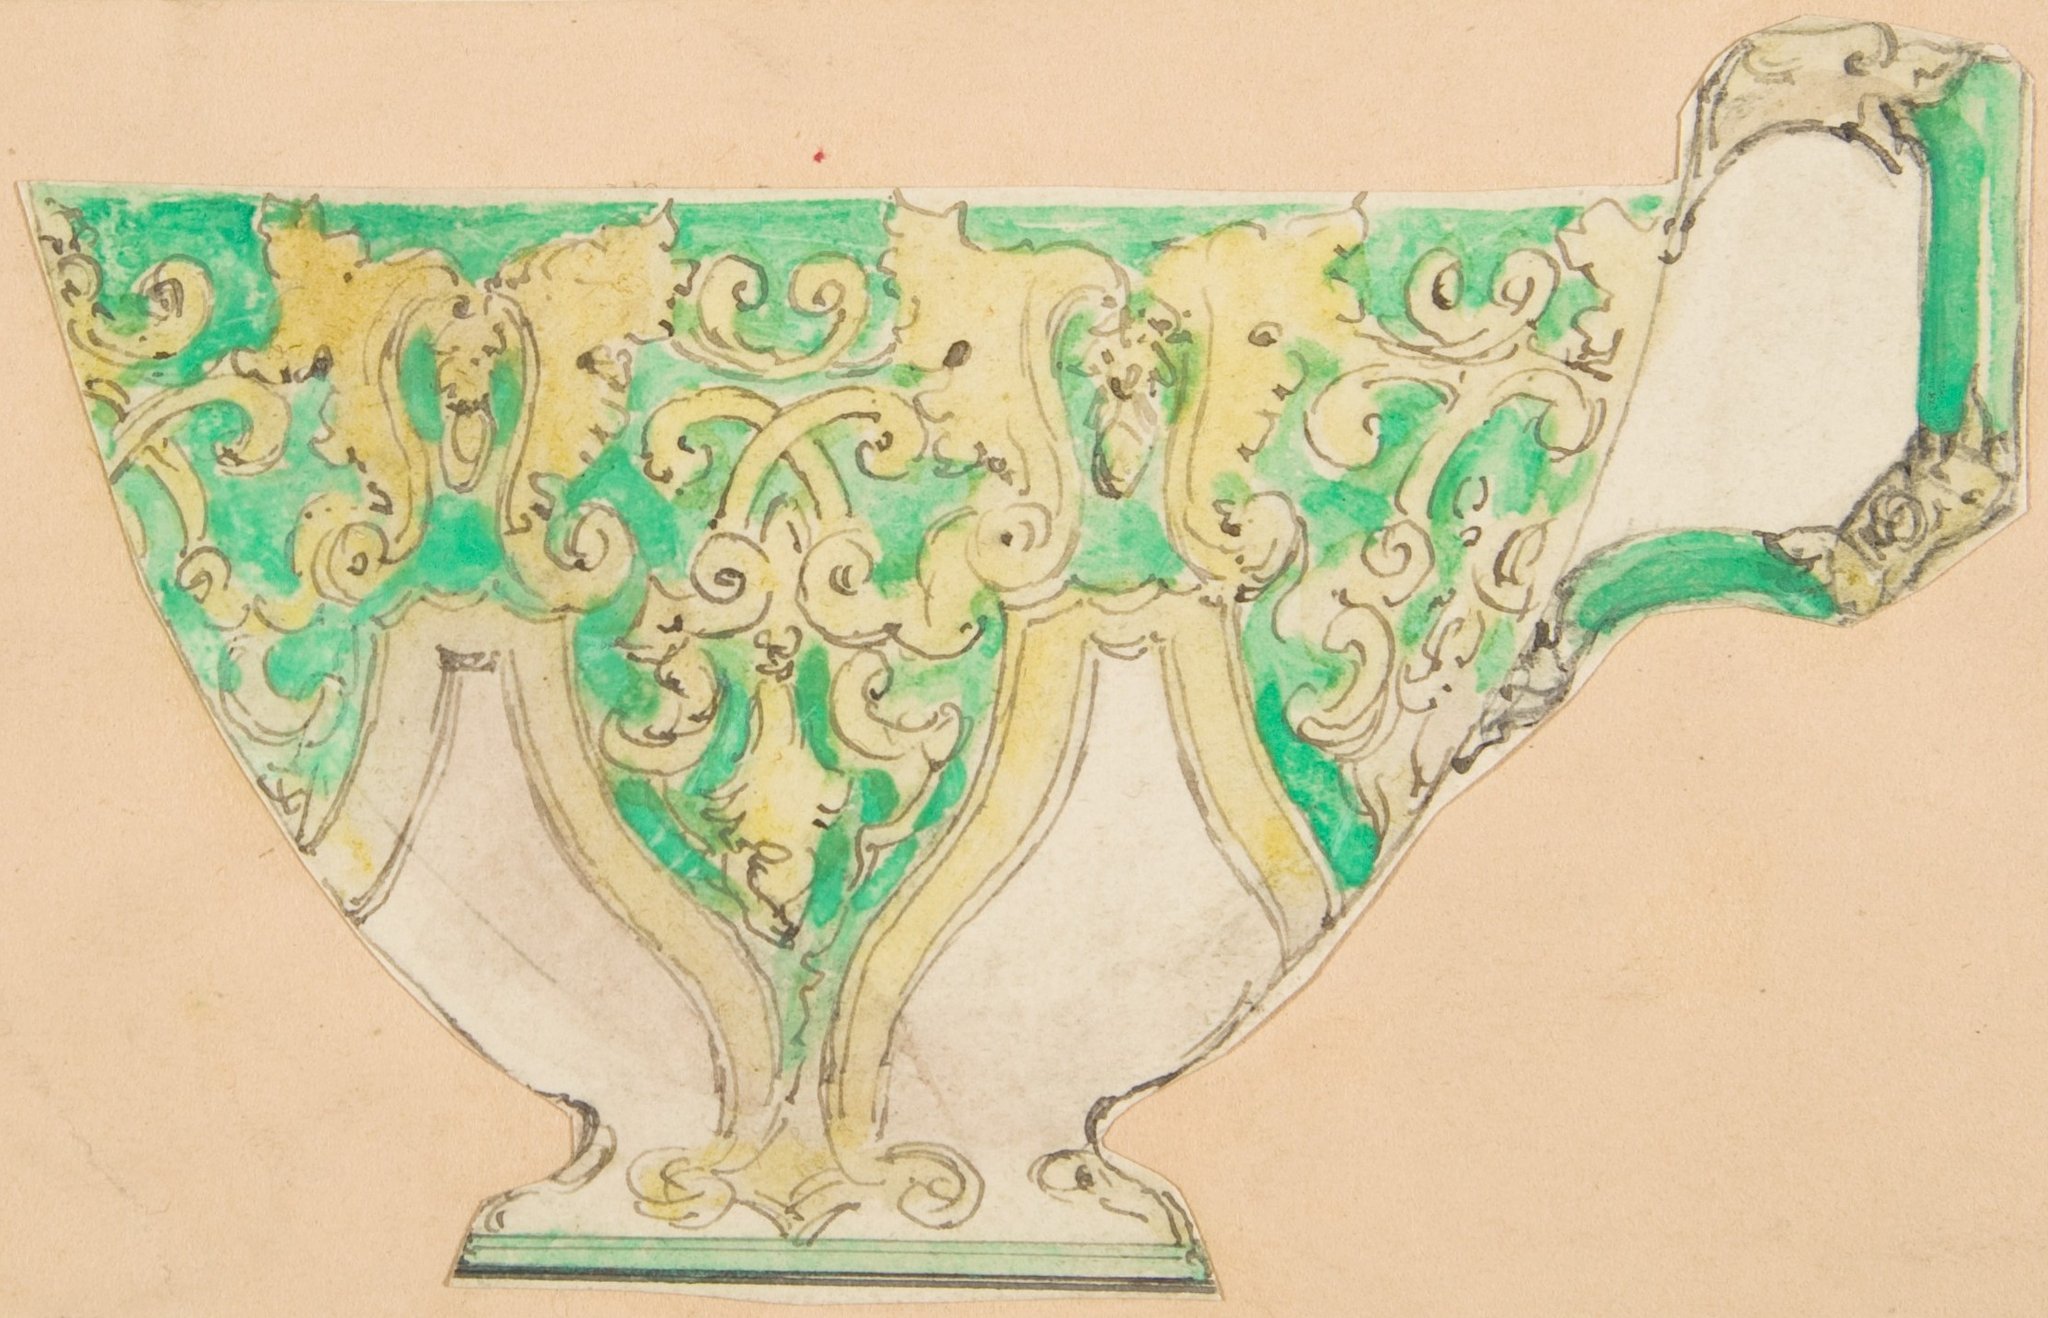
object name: drawing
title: Design for a tea cup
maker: anonymous, french, 19th century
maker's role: artist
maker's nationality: french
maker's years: 1800-1900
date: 1801-1900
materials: ink, watercolor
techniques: pen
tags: cups